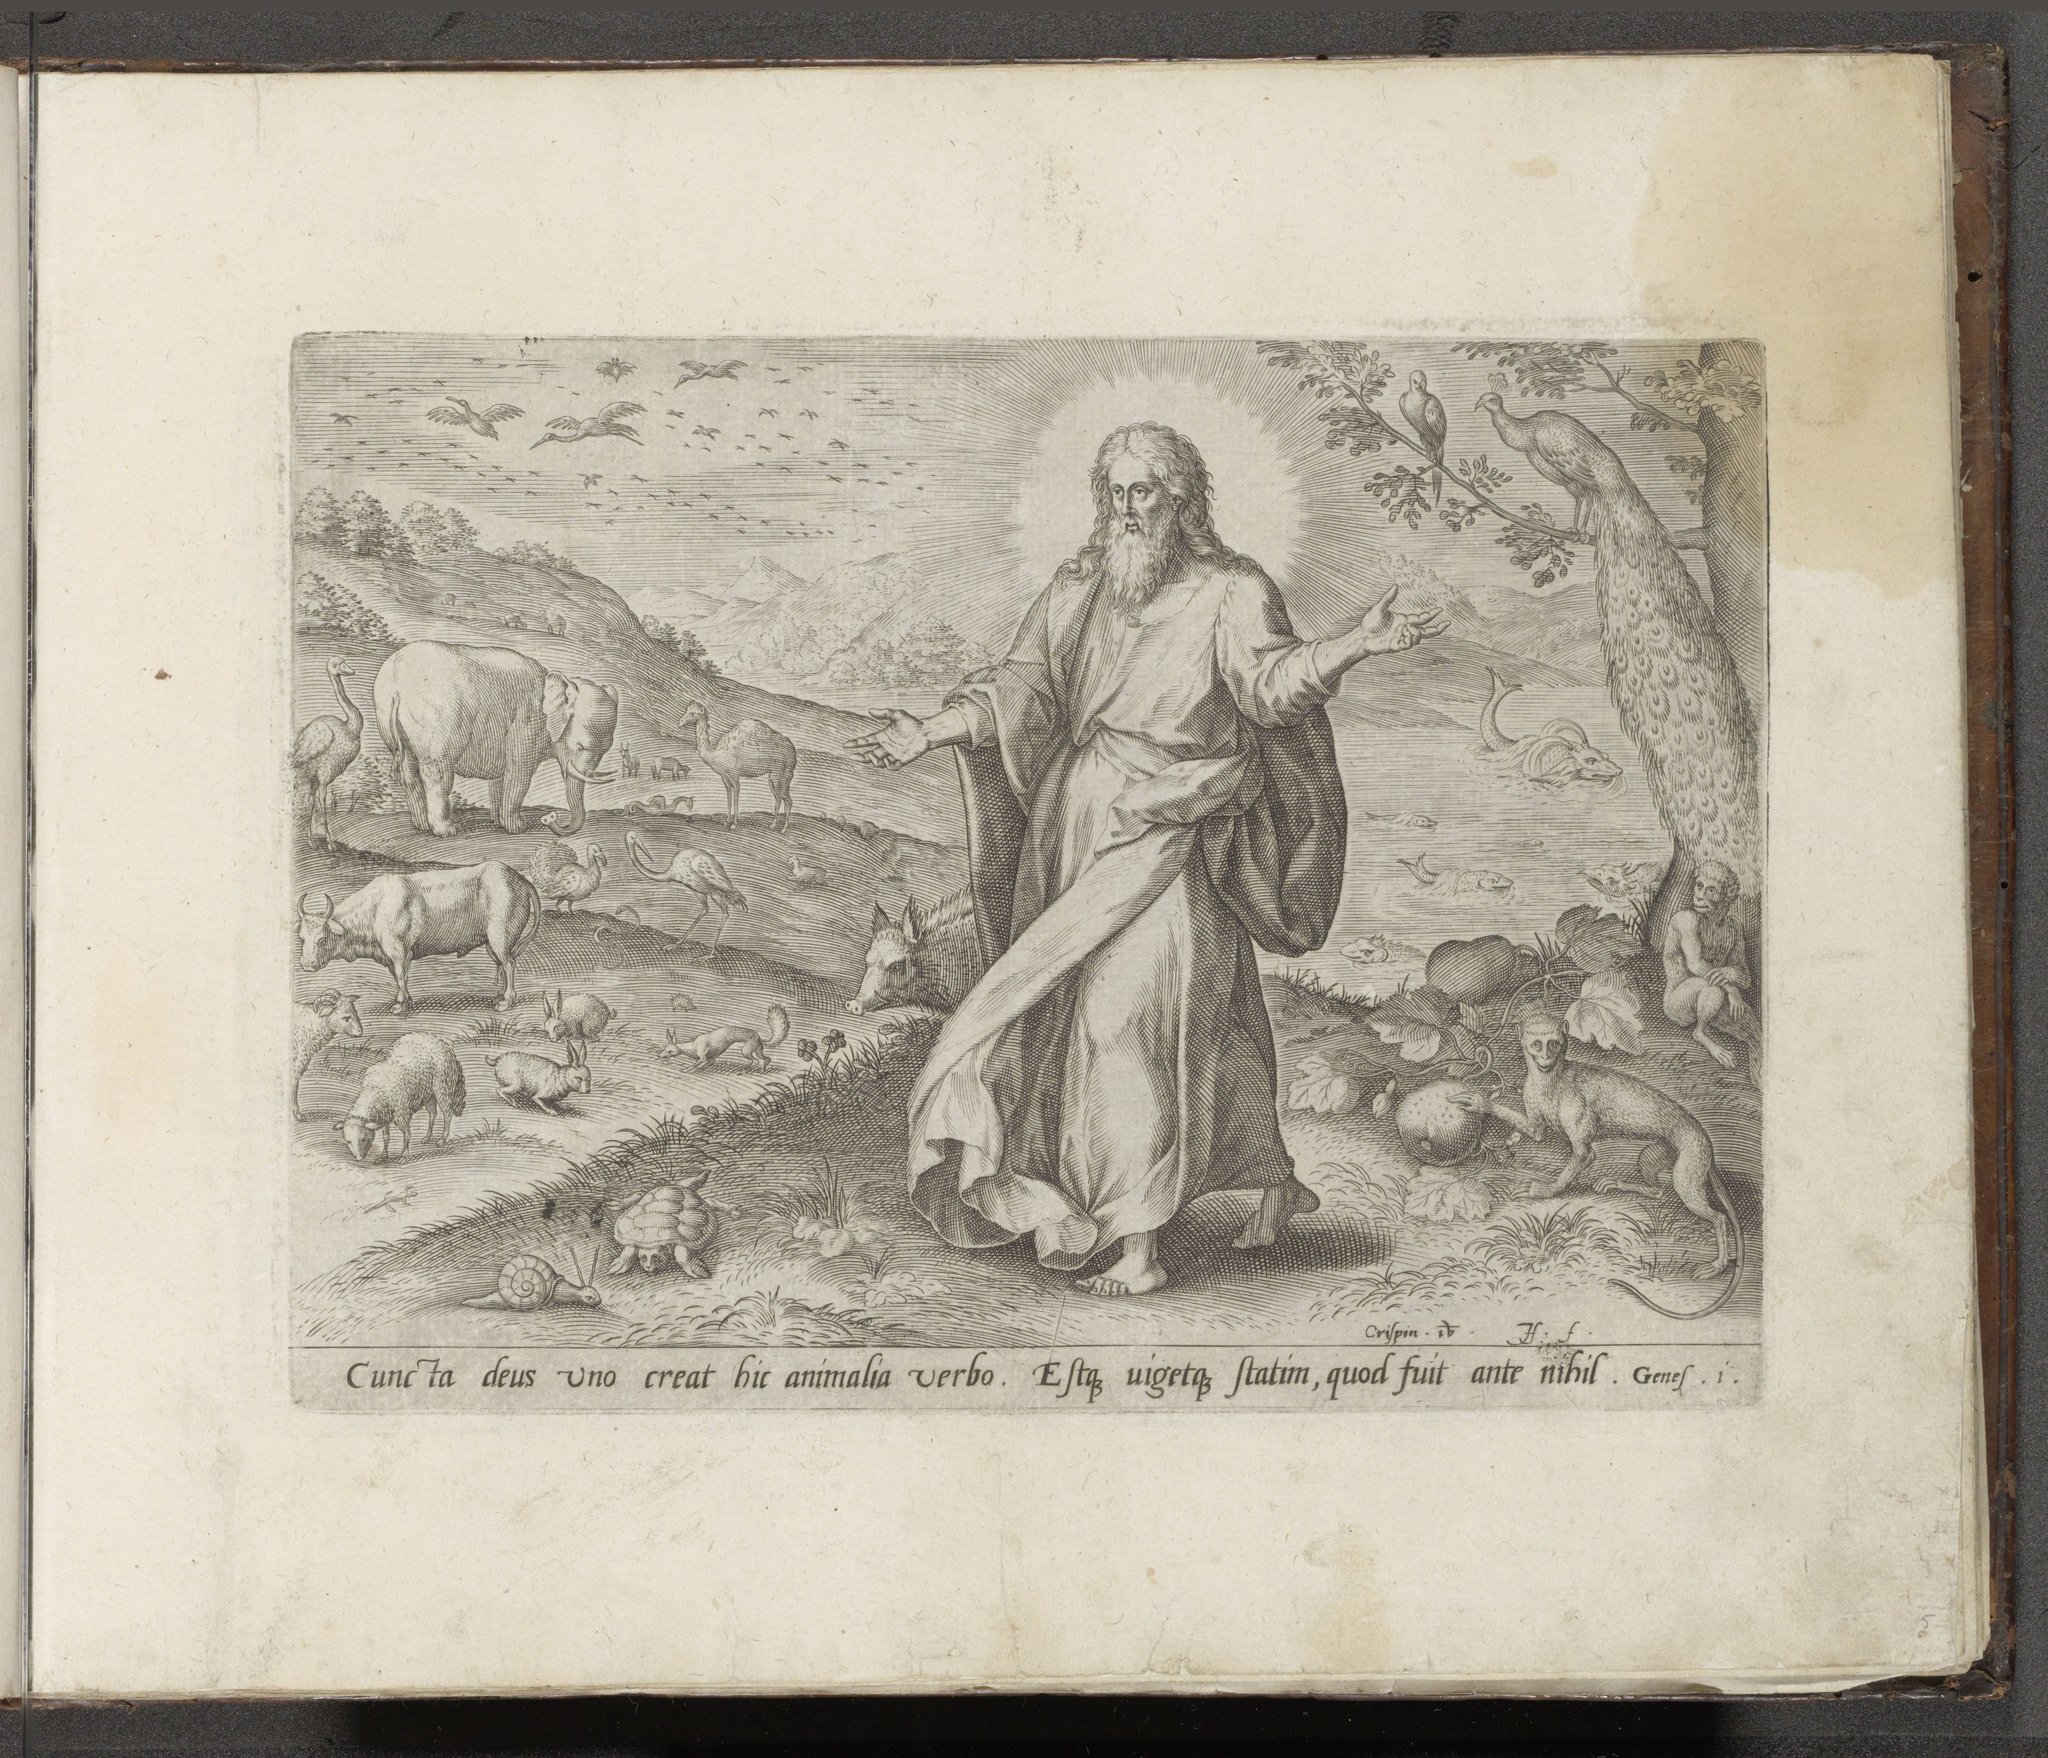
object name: print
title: Schepping en zondeval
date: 1579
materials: paper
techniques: engraving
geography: antwerp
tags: creation of the animals ~ genesis (+ god the father), animals, god the father as bearded old man, usually with crown or tiara or sceptre and/or globe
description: De vijfde scheppingsdag: God schept de dieren. God de Vader in de gedaante van een oude man, staand te midden van verschillende dieren. In de lucht vogels, in zee een zeemonster, links een olifant, koe, schapen en konijnen. Rechts een pauw en twee apen. Onderaan een verwijzing naar de Bijbeltekst in het Latijn. Prent maakt deel uit van een album.